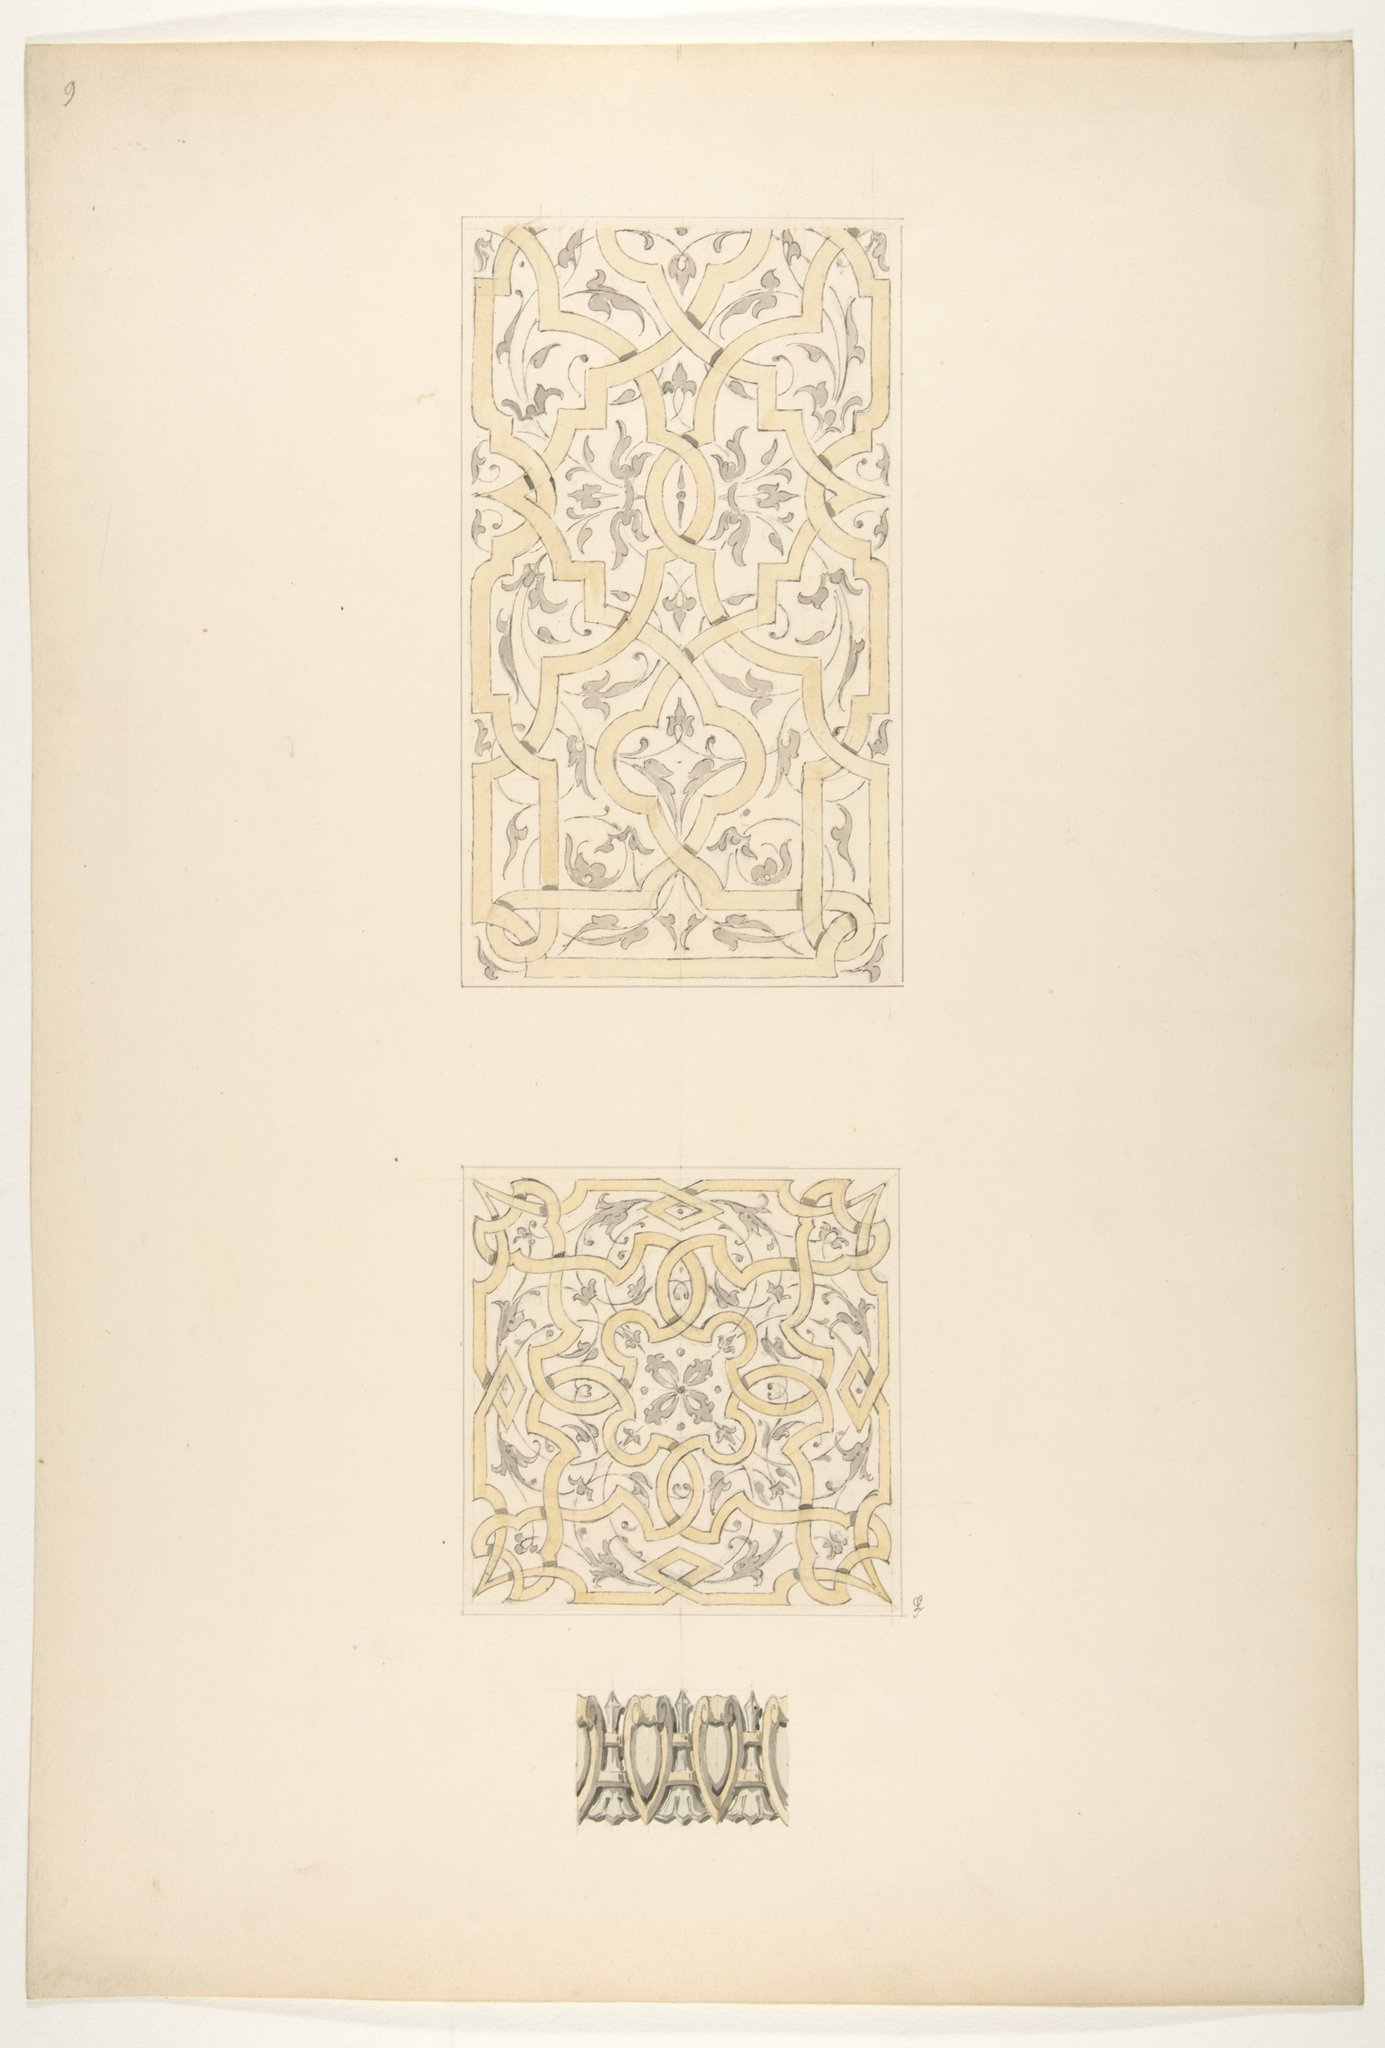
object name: drawing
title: Three designs for decorative motifs in strapwork, rinceaux, and egg-and-dart patterns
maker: jules-edmond-charles lachaise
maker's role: artist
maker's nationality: french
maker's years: 1897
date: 1830-1897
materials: graphite, ink, watercolor, paper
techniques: pen, wash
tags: ornament